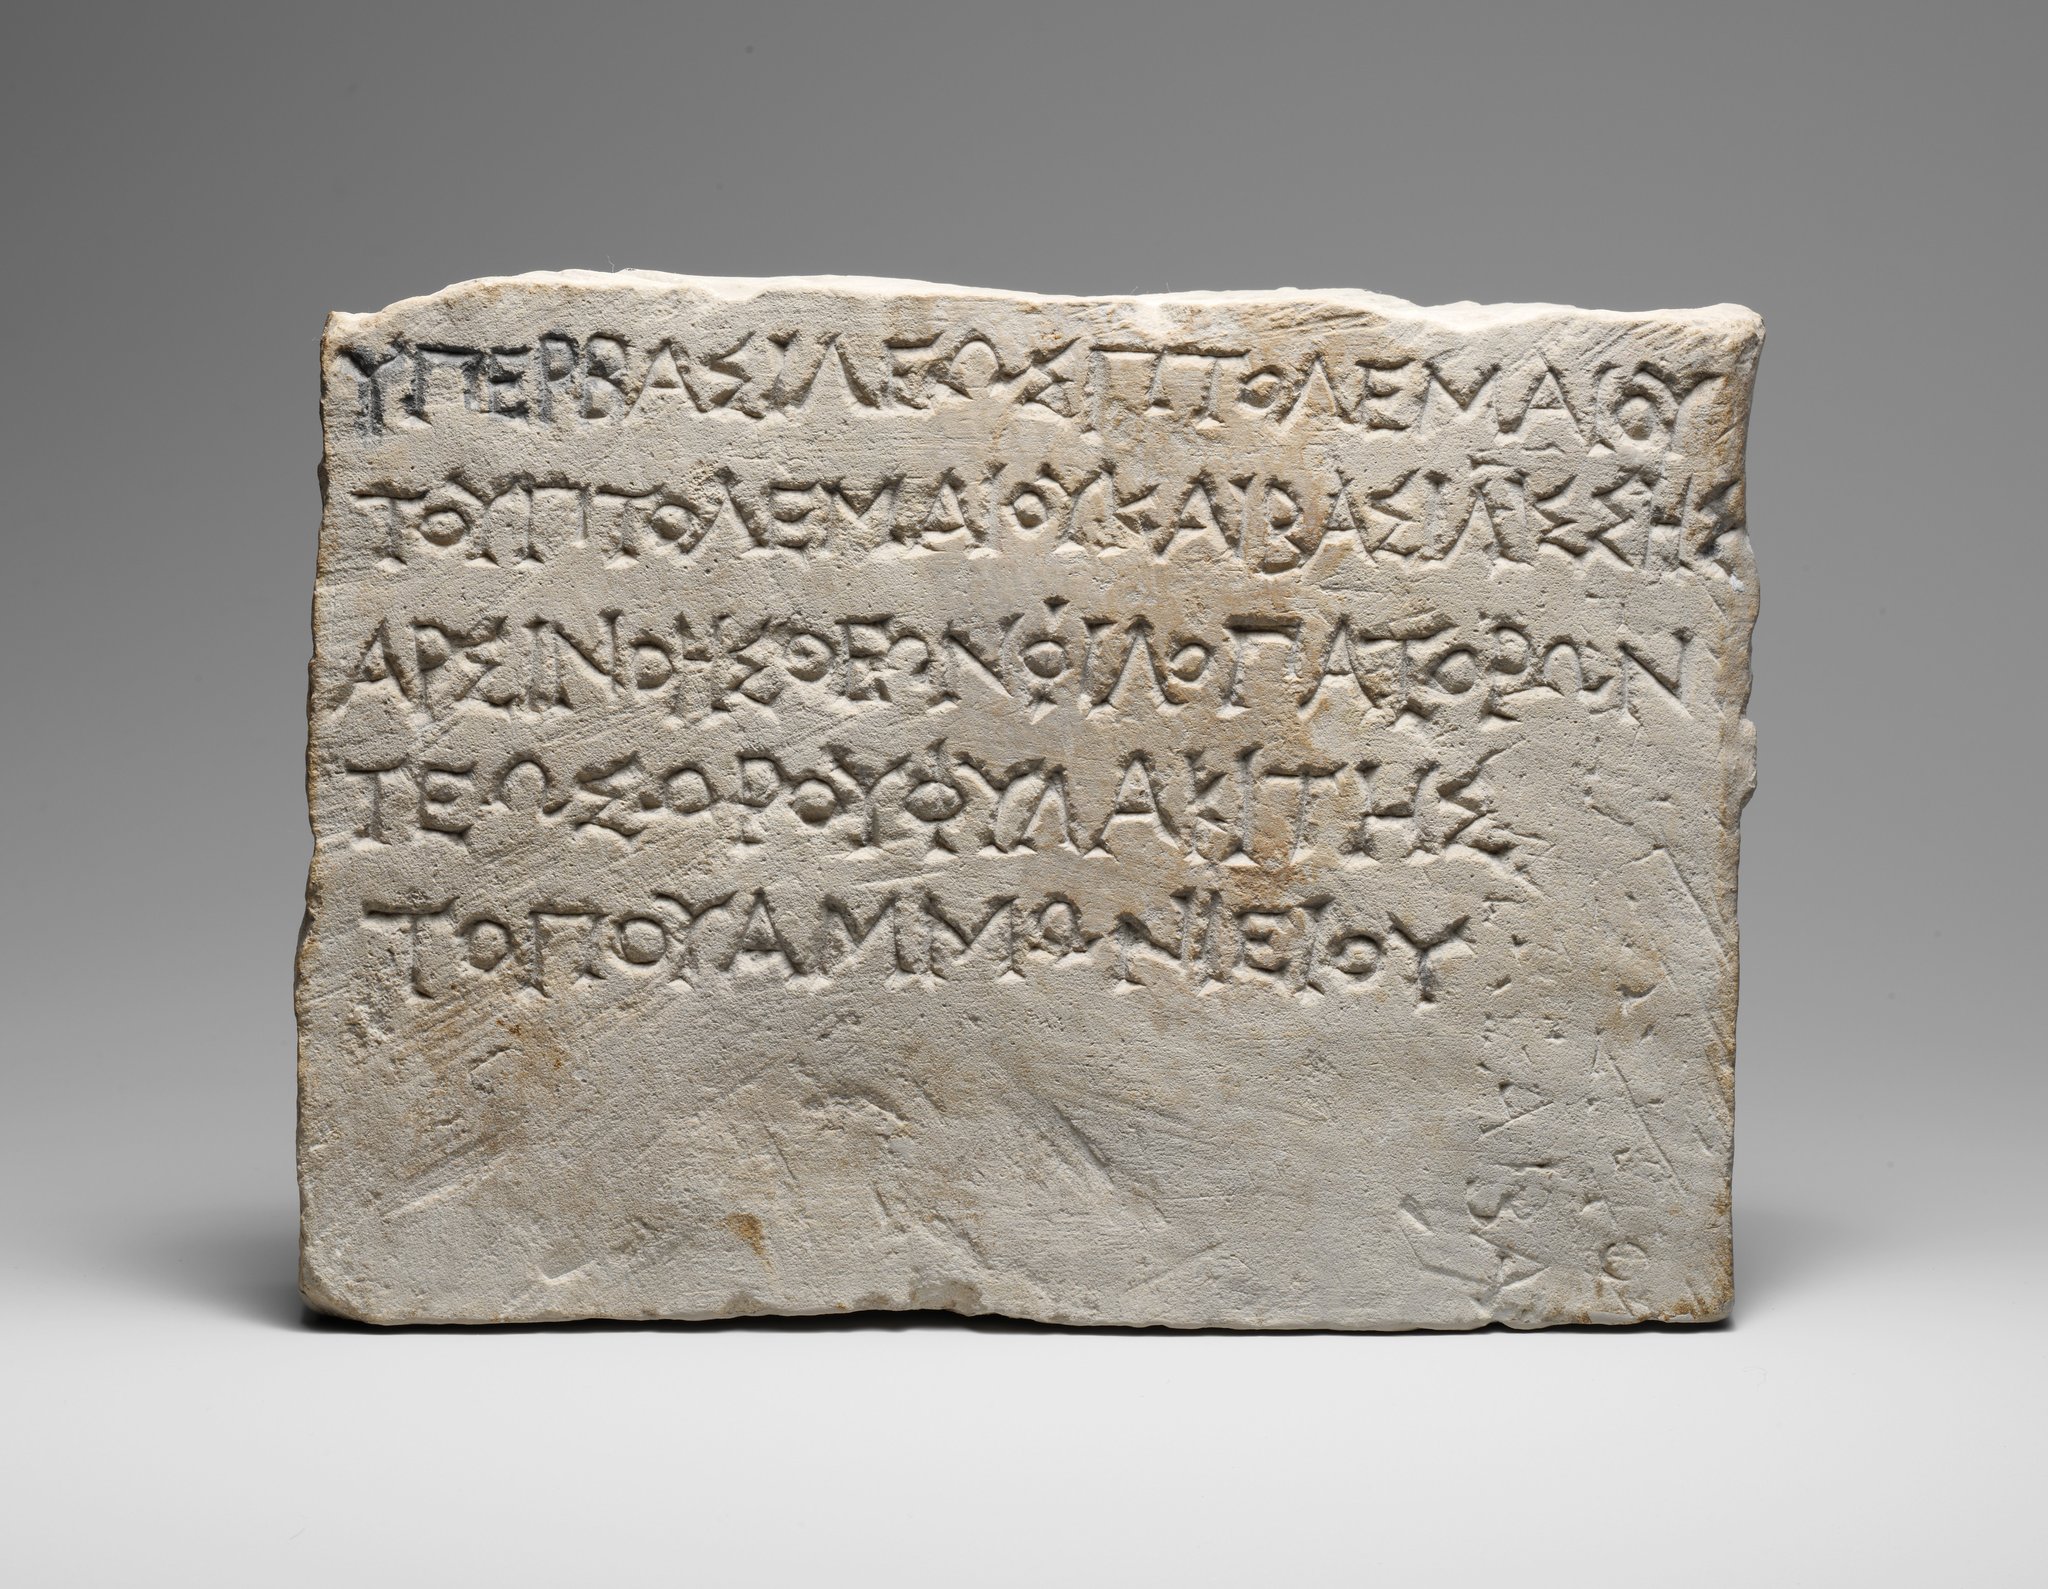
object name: limestone plaque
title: Limestone block with dedication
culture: greek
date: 234-201 BCE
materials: limestone